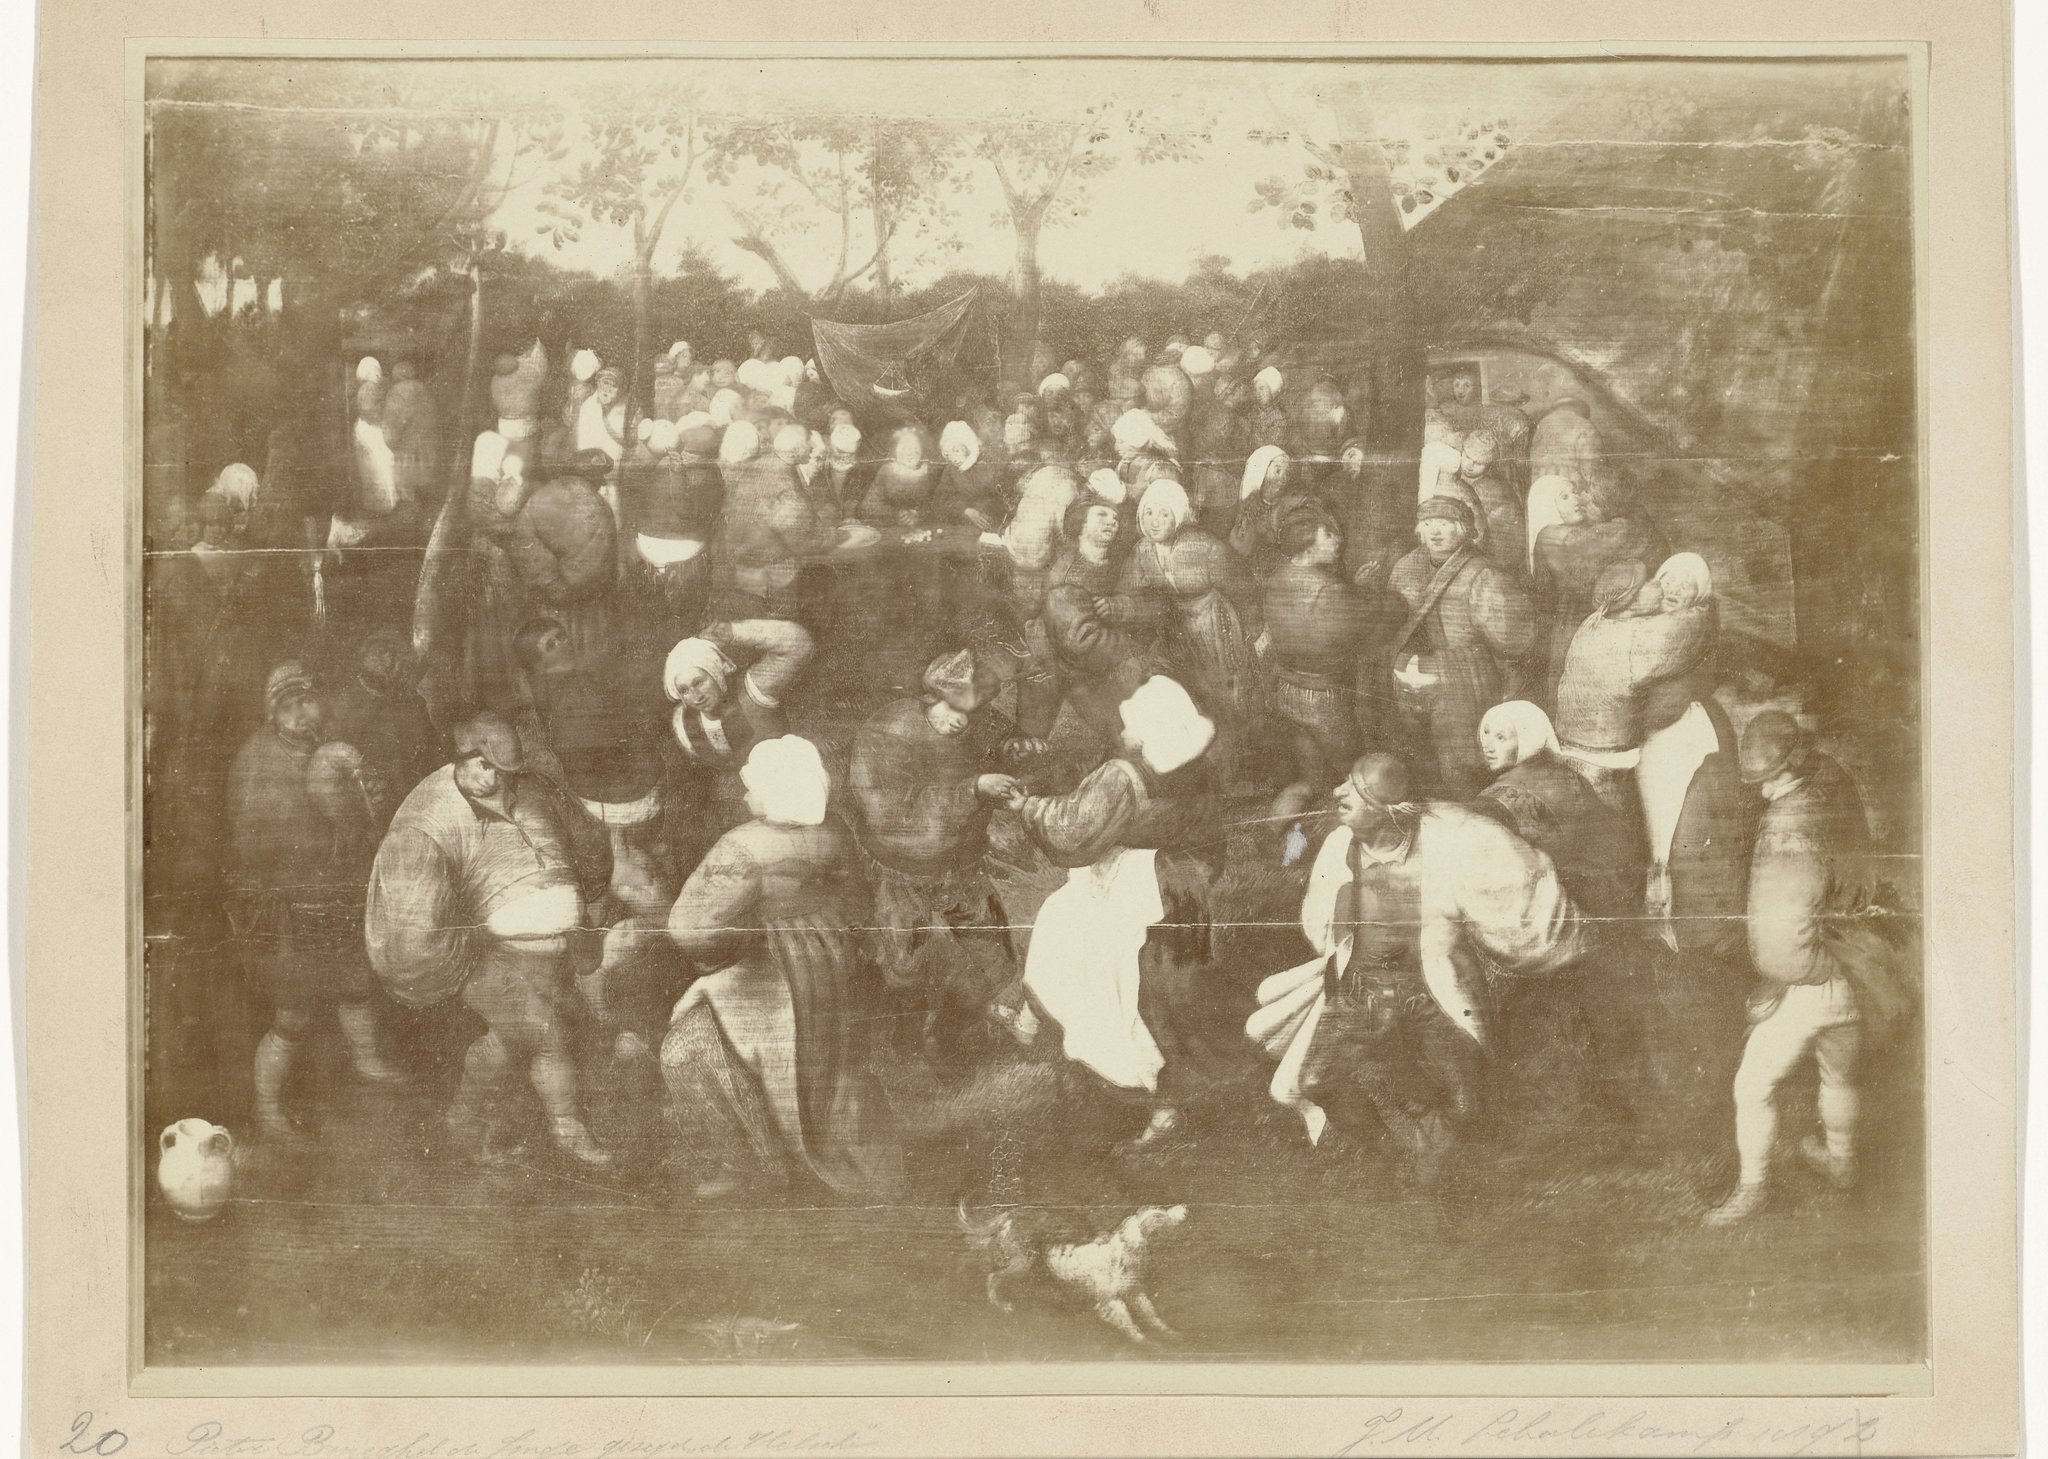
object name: photograph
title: Pieter Brueghel de jonge gezegd "de Helsche"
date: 1891-1892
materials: cardboard, paper, photographic support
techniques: albumen print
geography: netherlands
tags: picture, painting